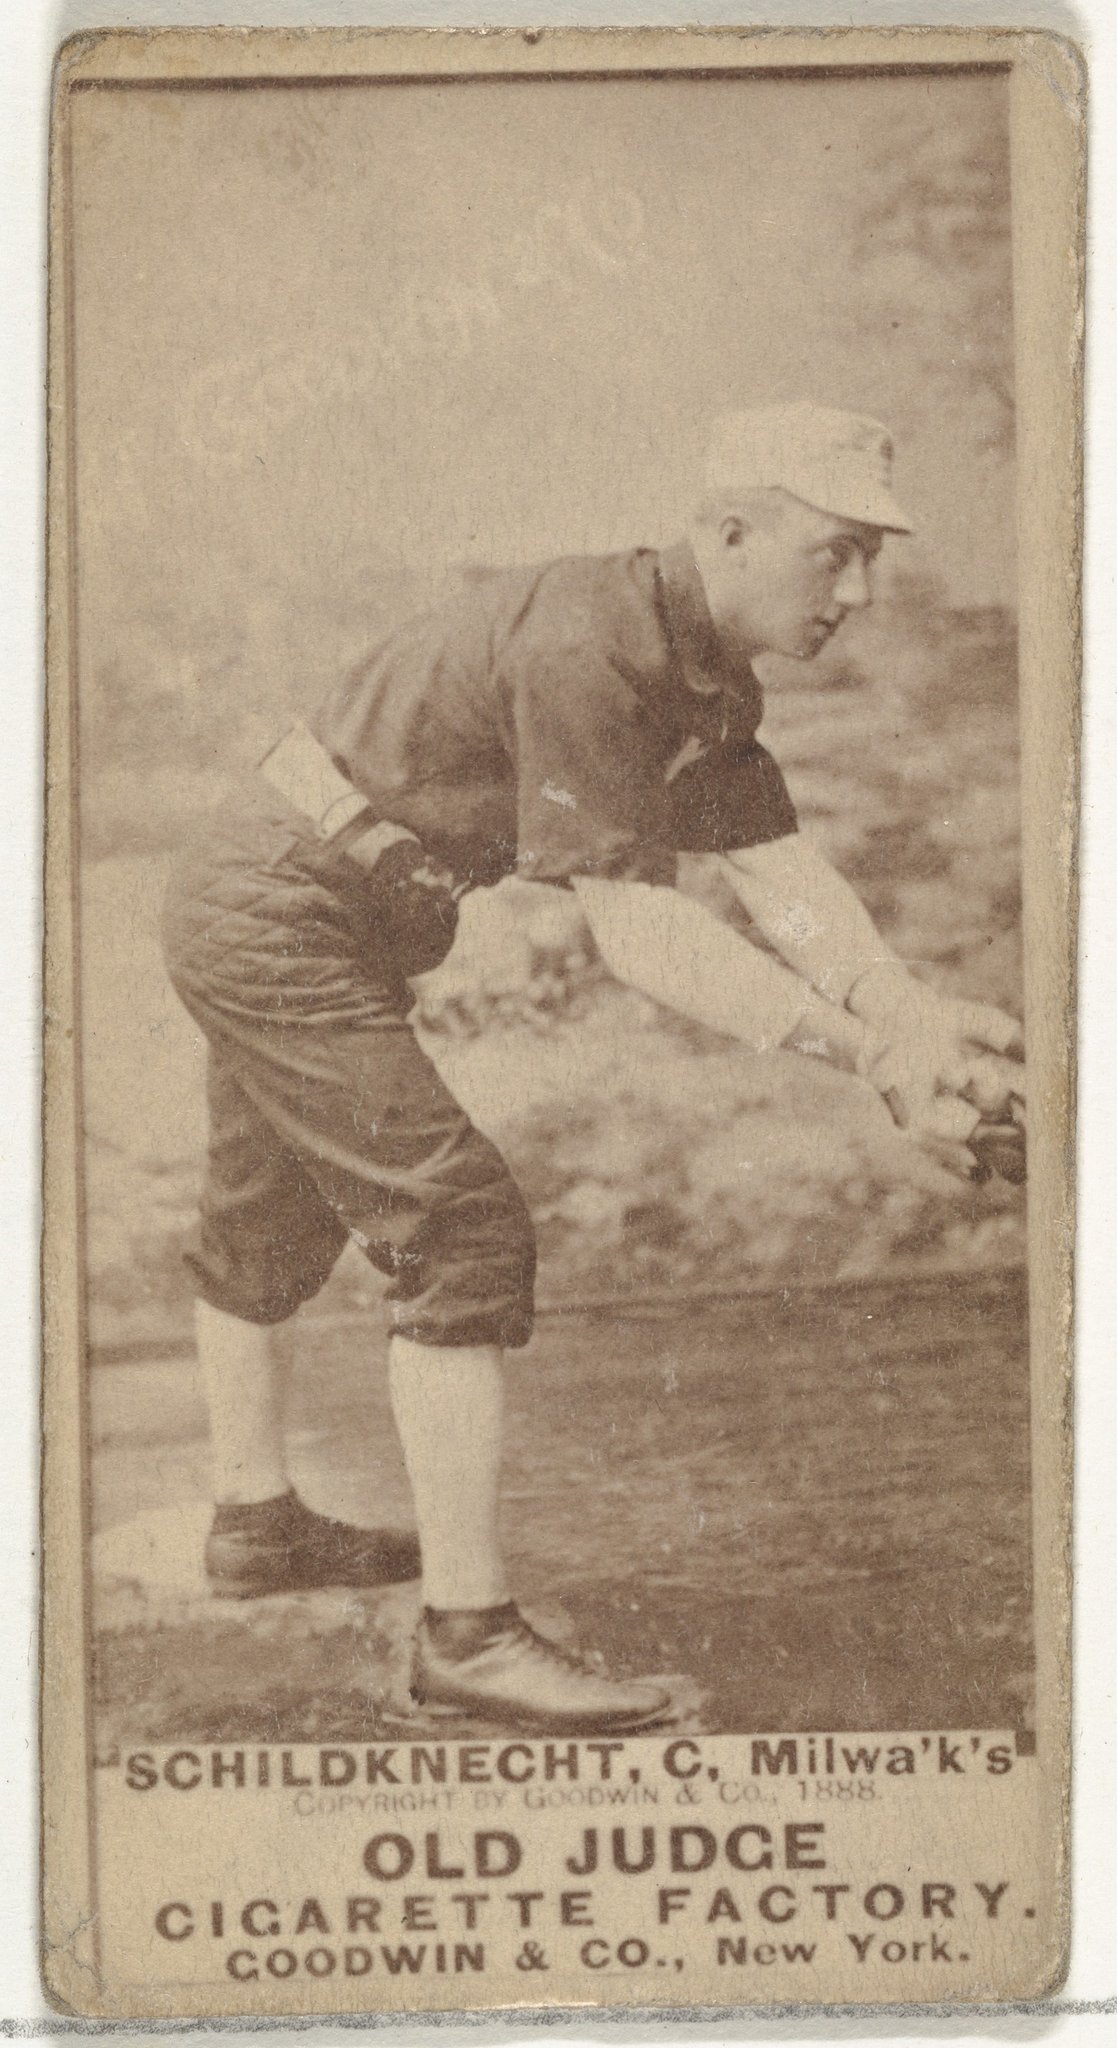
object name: baseball card, photograph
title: Schildknecht, Catcher, Milwaukee, from the Old Judge series (N172) for Old Judge Cigarettes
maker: goodwin & company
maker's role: publisher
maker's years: 1850-1950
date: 1888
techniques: albumen silver print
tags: men,portraits,baseball,athletes